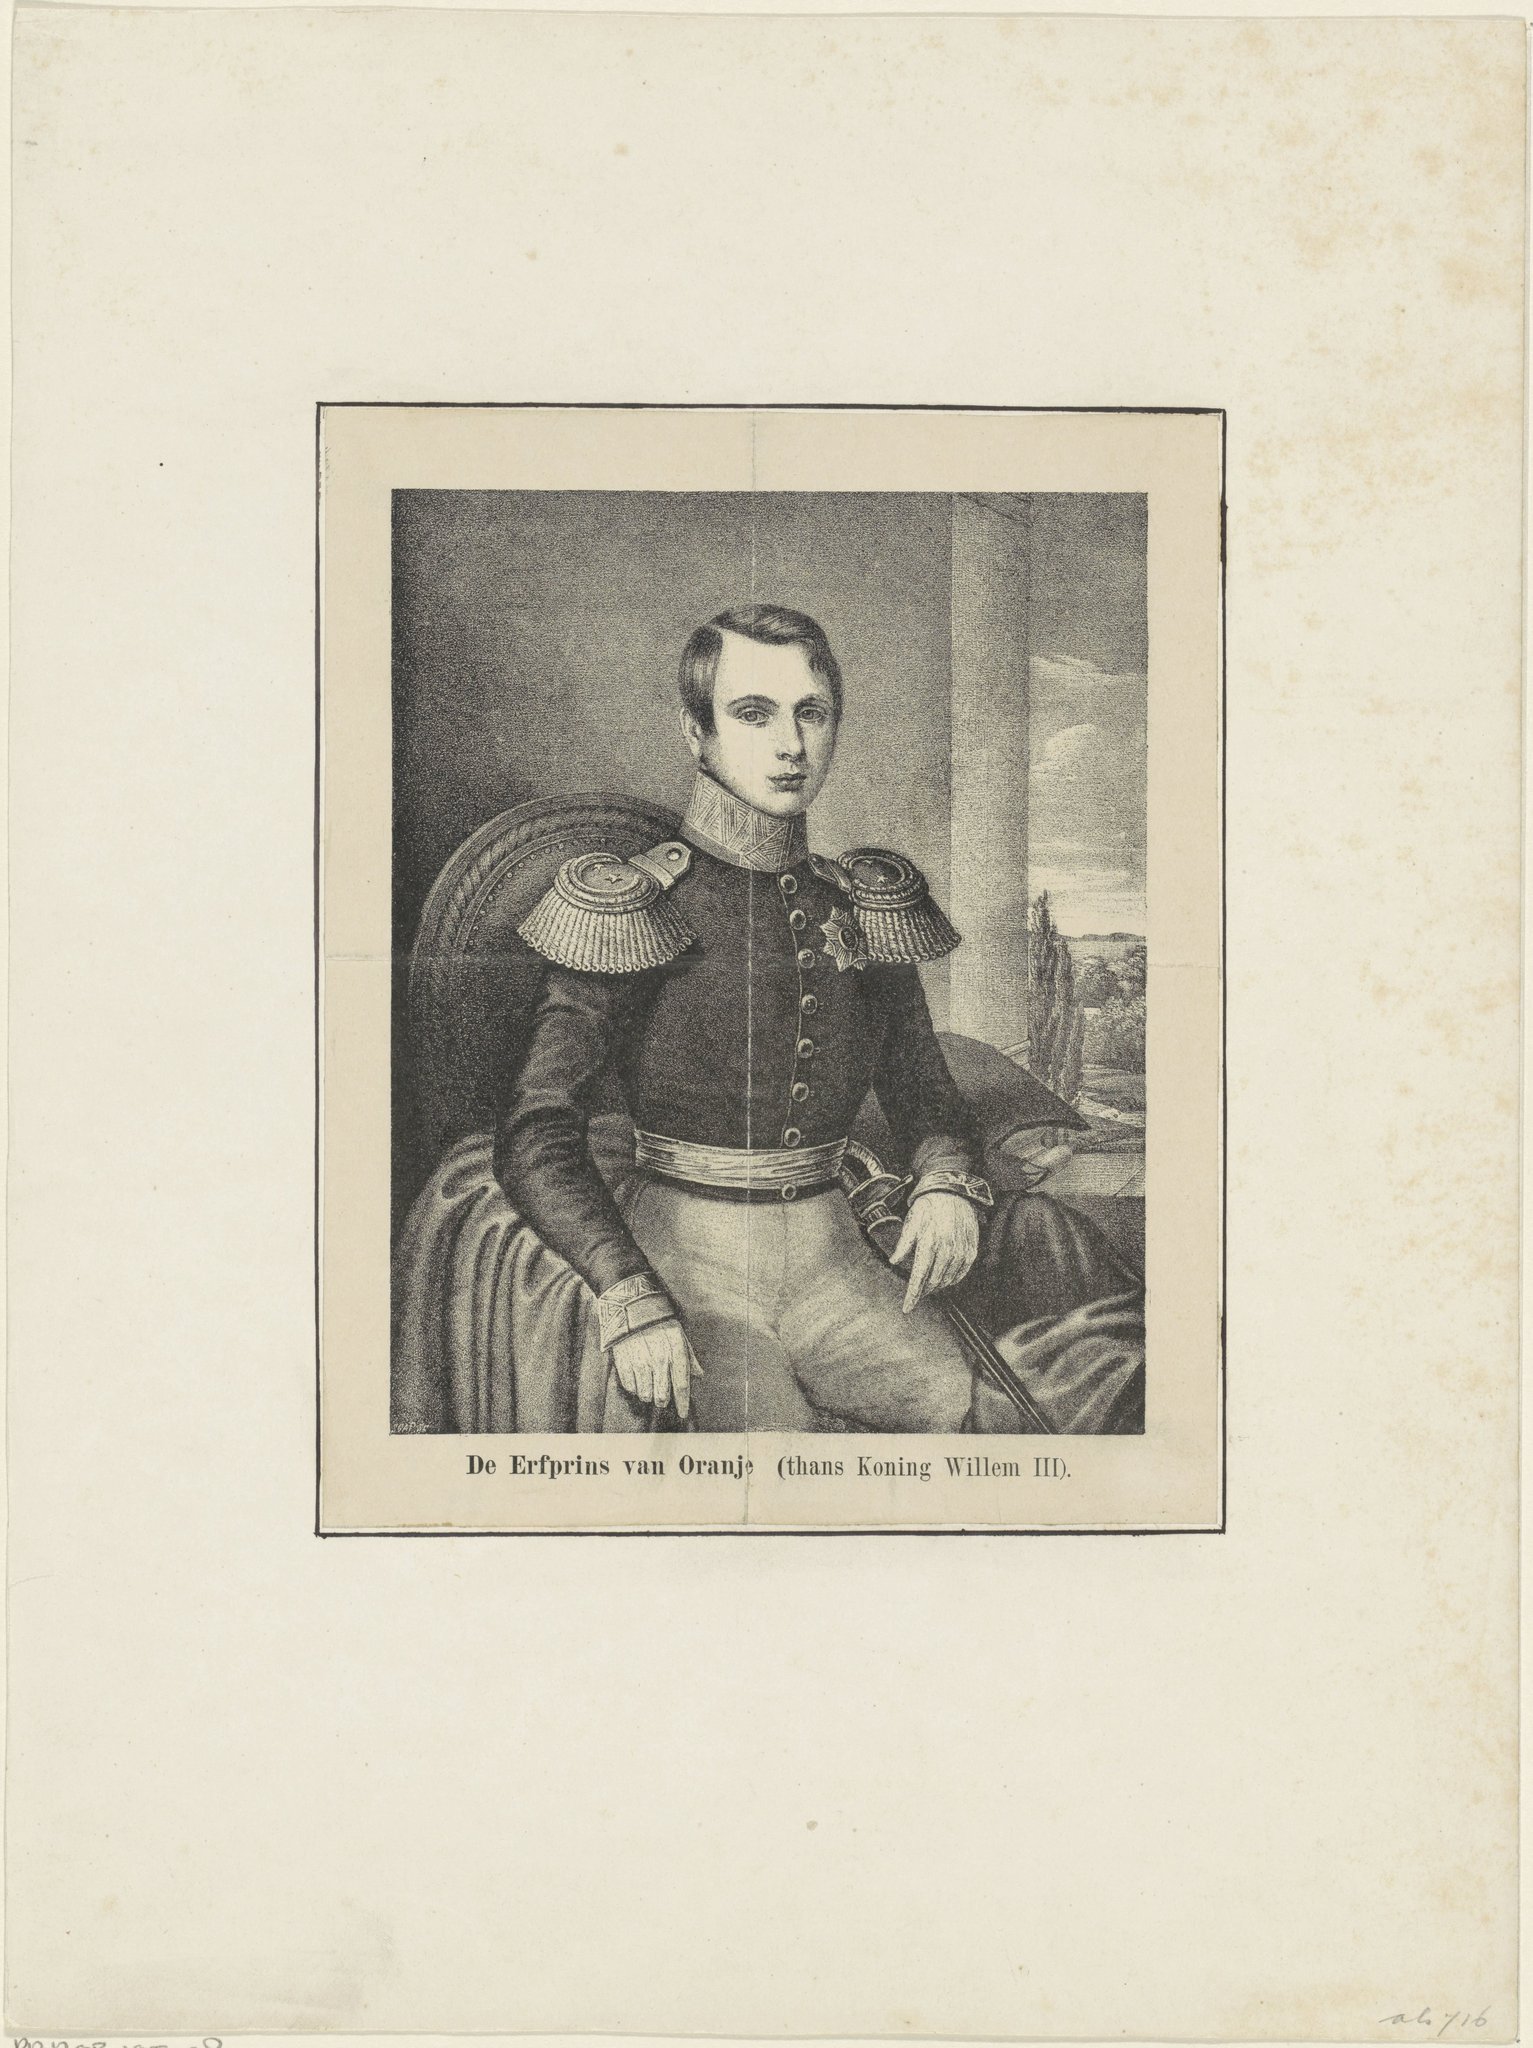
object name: print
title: Portret van Willem III, koning der Nederlanden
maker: monogrammist sgap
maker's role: print maker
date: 1849-1899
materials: paper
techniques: letterpress printing, engraving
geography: netherlands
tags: willem iii (koning der nederlanden)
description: De hier vermelde titel verwijst naar de hoogst verkregen titel van de geportretteerde, niet per se naar de titel die de geportretteerde op deze voorstelling draagt.